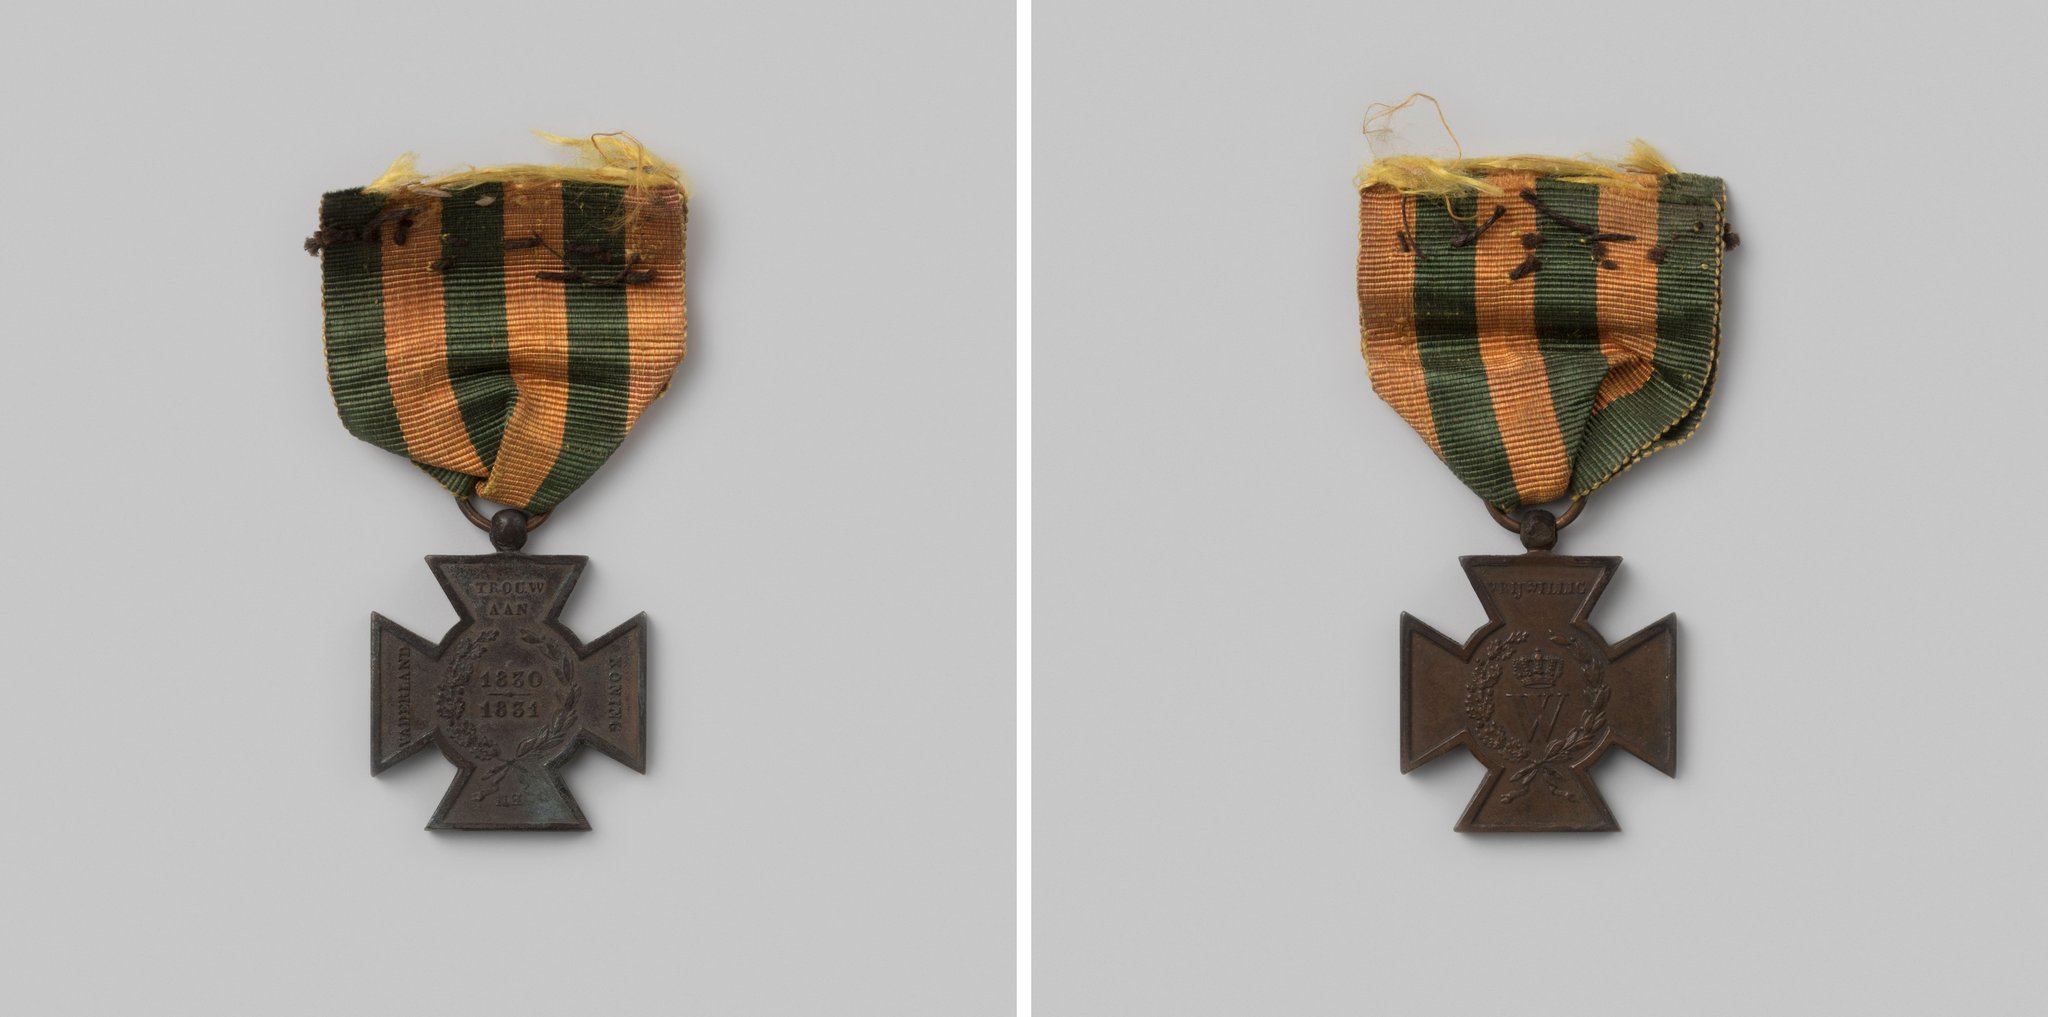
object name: ordeteken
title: Metalen Kruis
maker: Anonymous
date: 1830-1831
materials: bronze, textile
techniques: stitching, striking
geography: netherlands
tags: metalen kruis, belgische revolutie